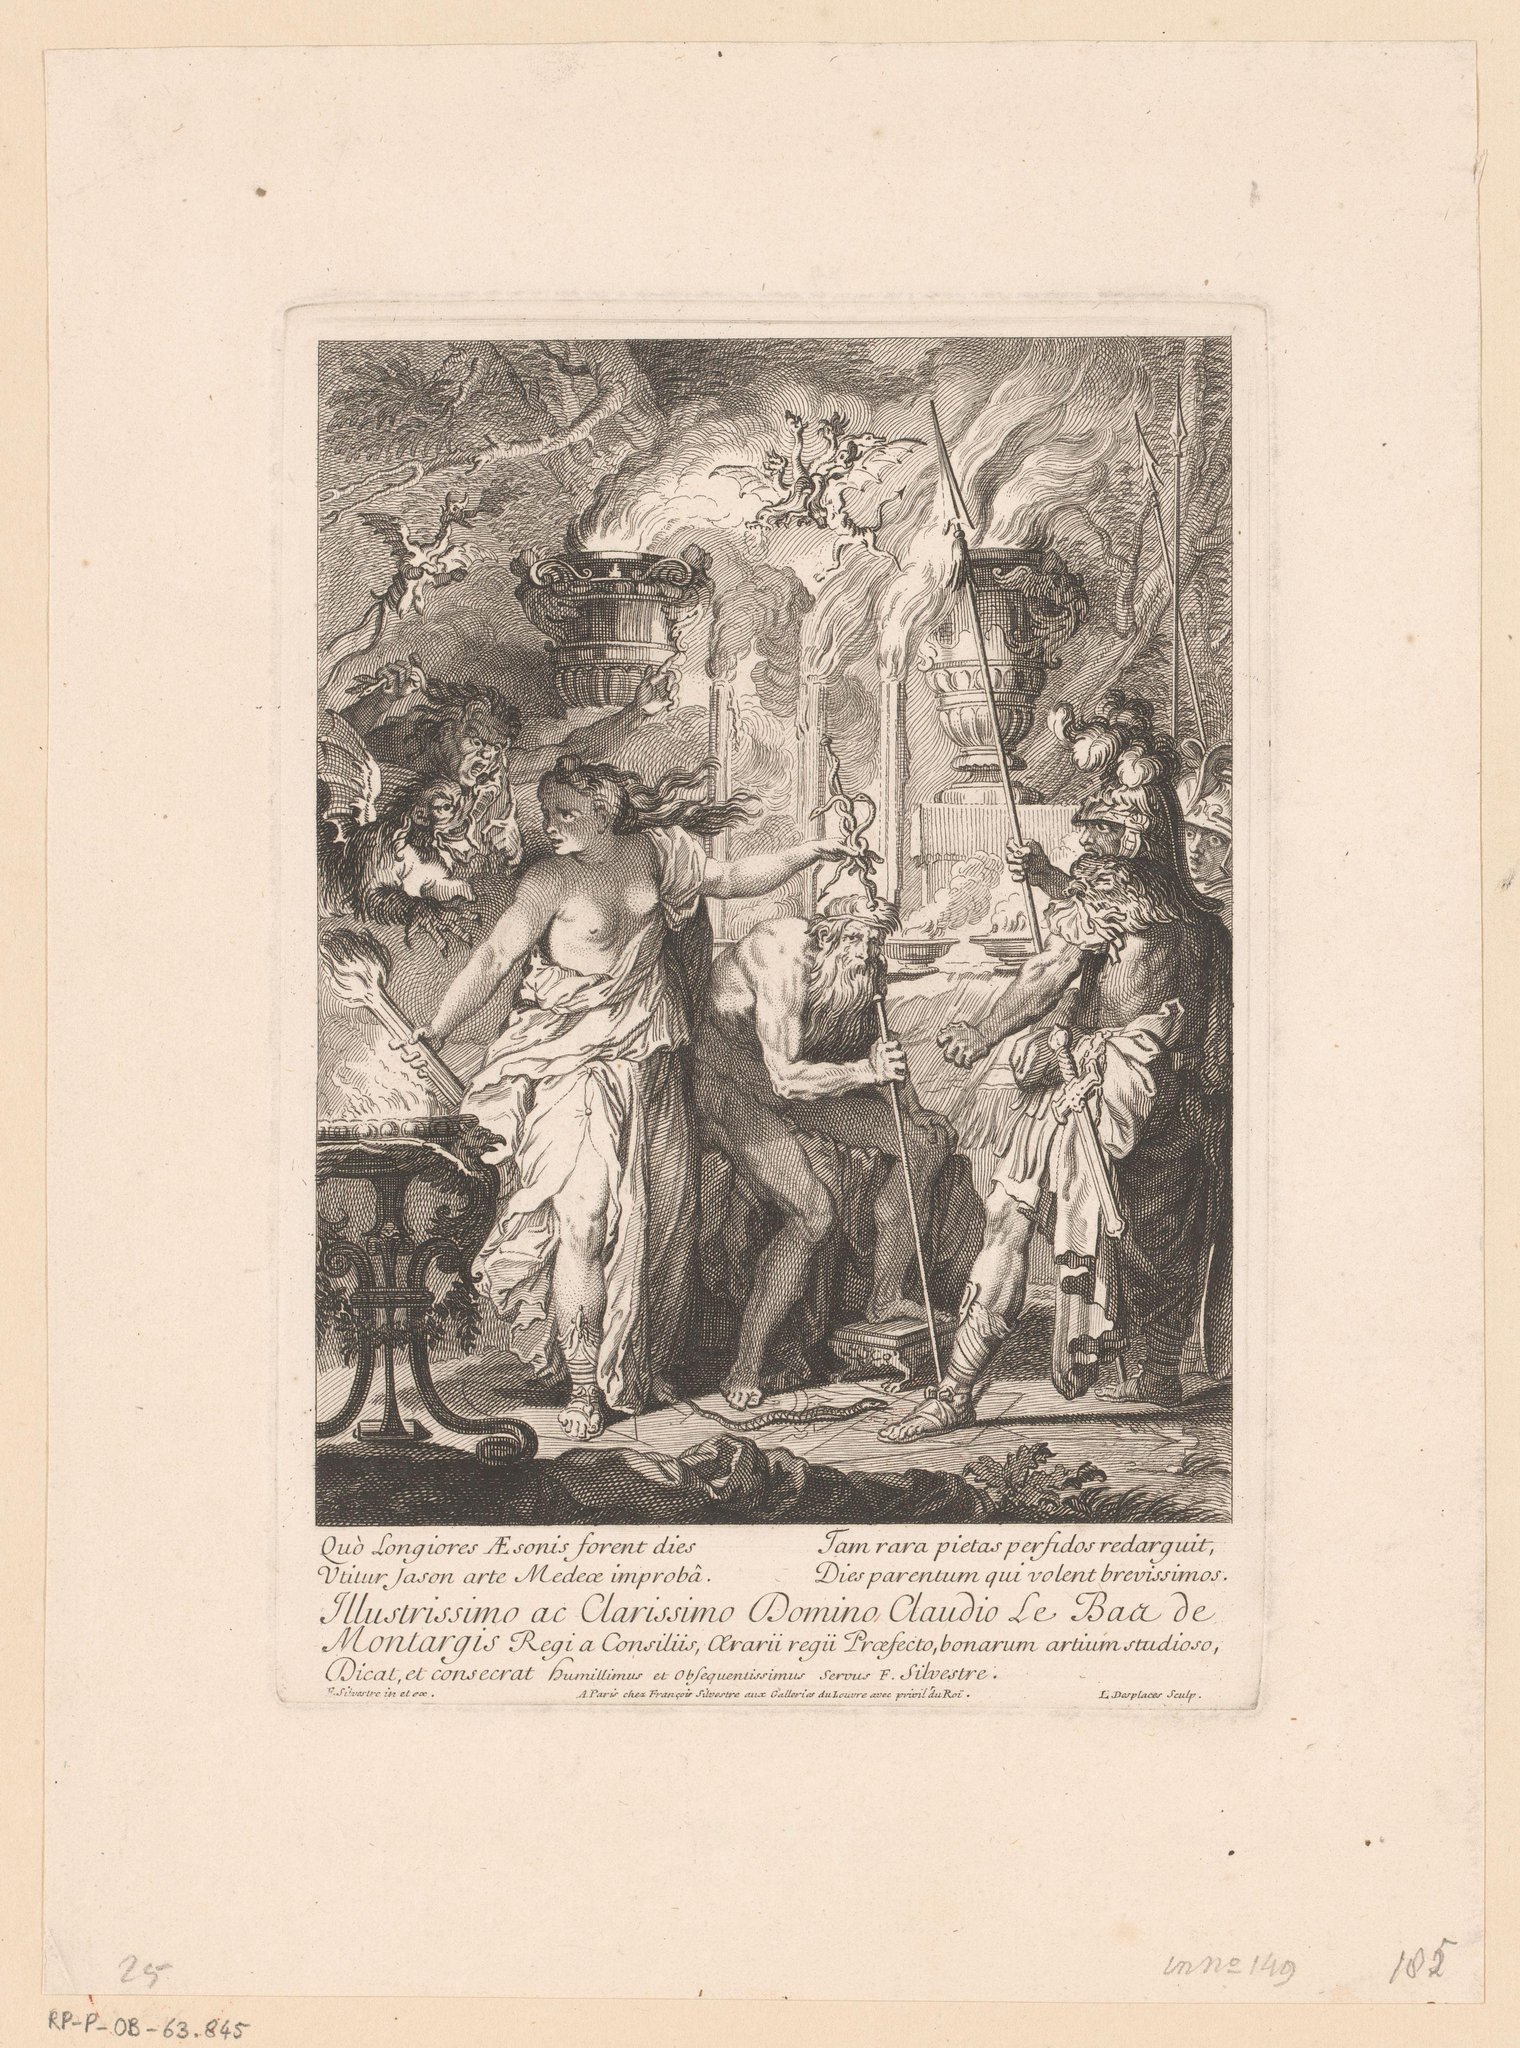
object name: print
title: Medea de tovenares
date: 1692-1738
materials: paper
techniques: engraving, etching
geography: paris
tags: medea, witchcraft, sorcery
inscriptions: collector's mark: Lugt 240